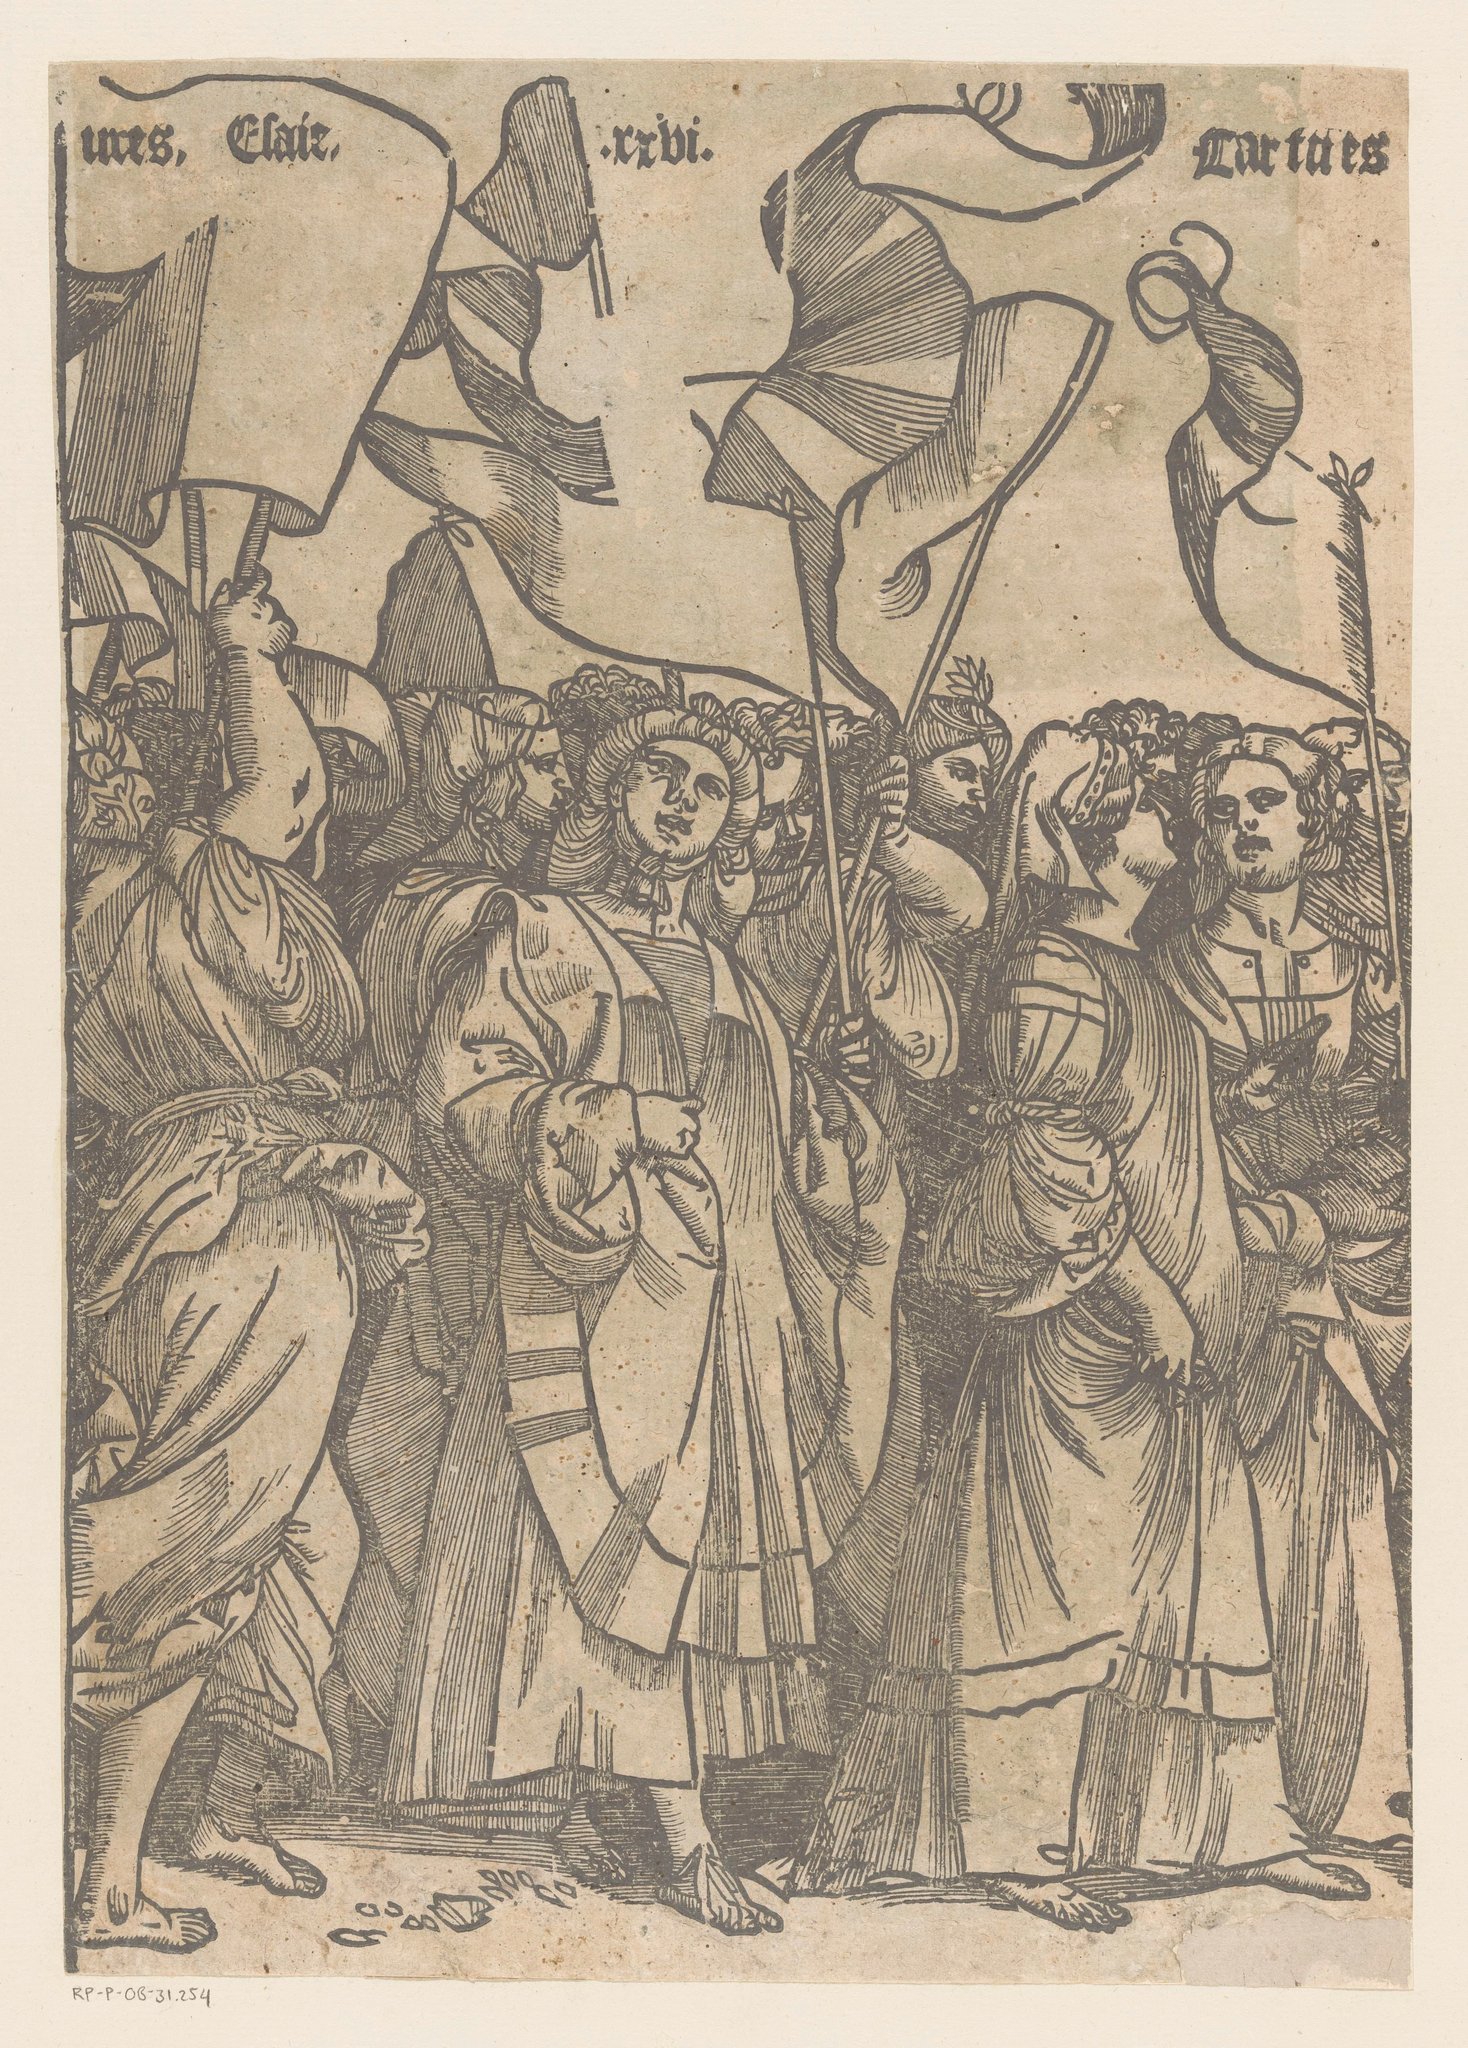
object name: print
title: Triomf van Christus (achtste deel)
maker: Anonymous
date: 1510-1511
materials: paper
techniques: woodcut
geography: italy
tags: sibyls, banner, standard (as symbol of the state, etc.)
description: Deze prent maakt onderdeel uit van een fries bestaande uit tien houtsneden die samen de Triomf van Christus vormen.